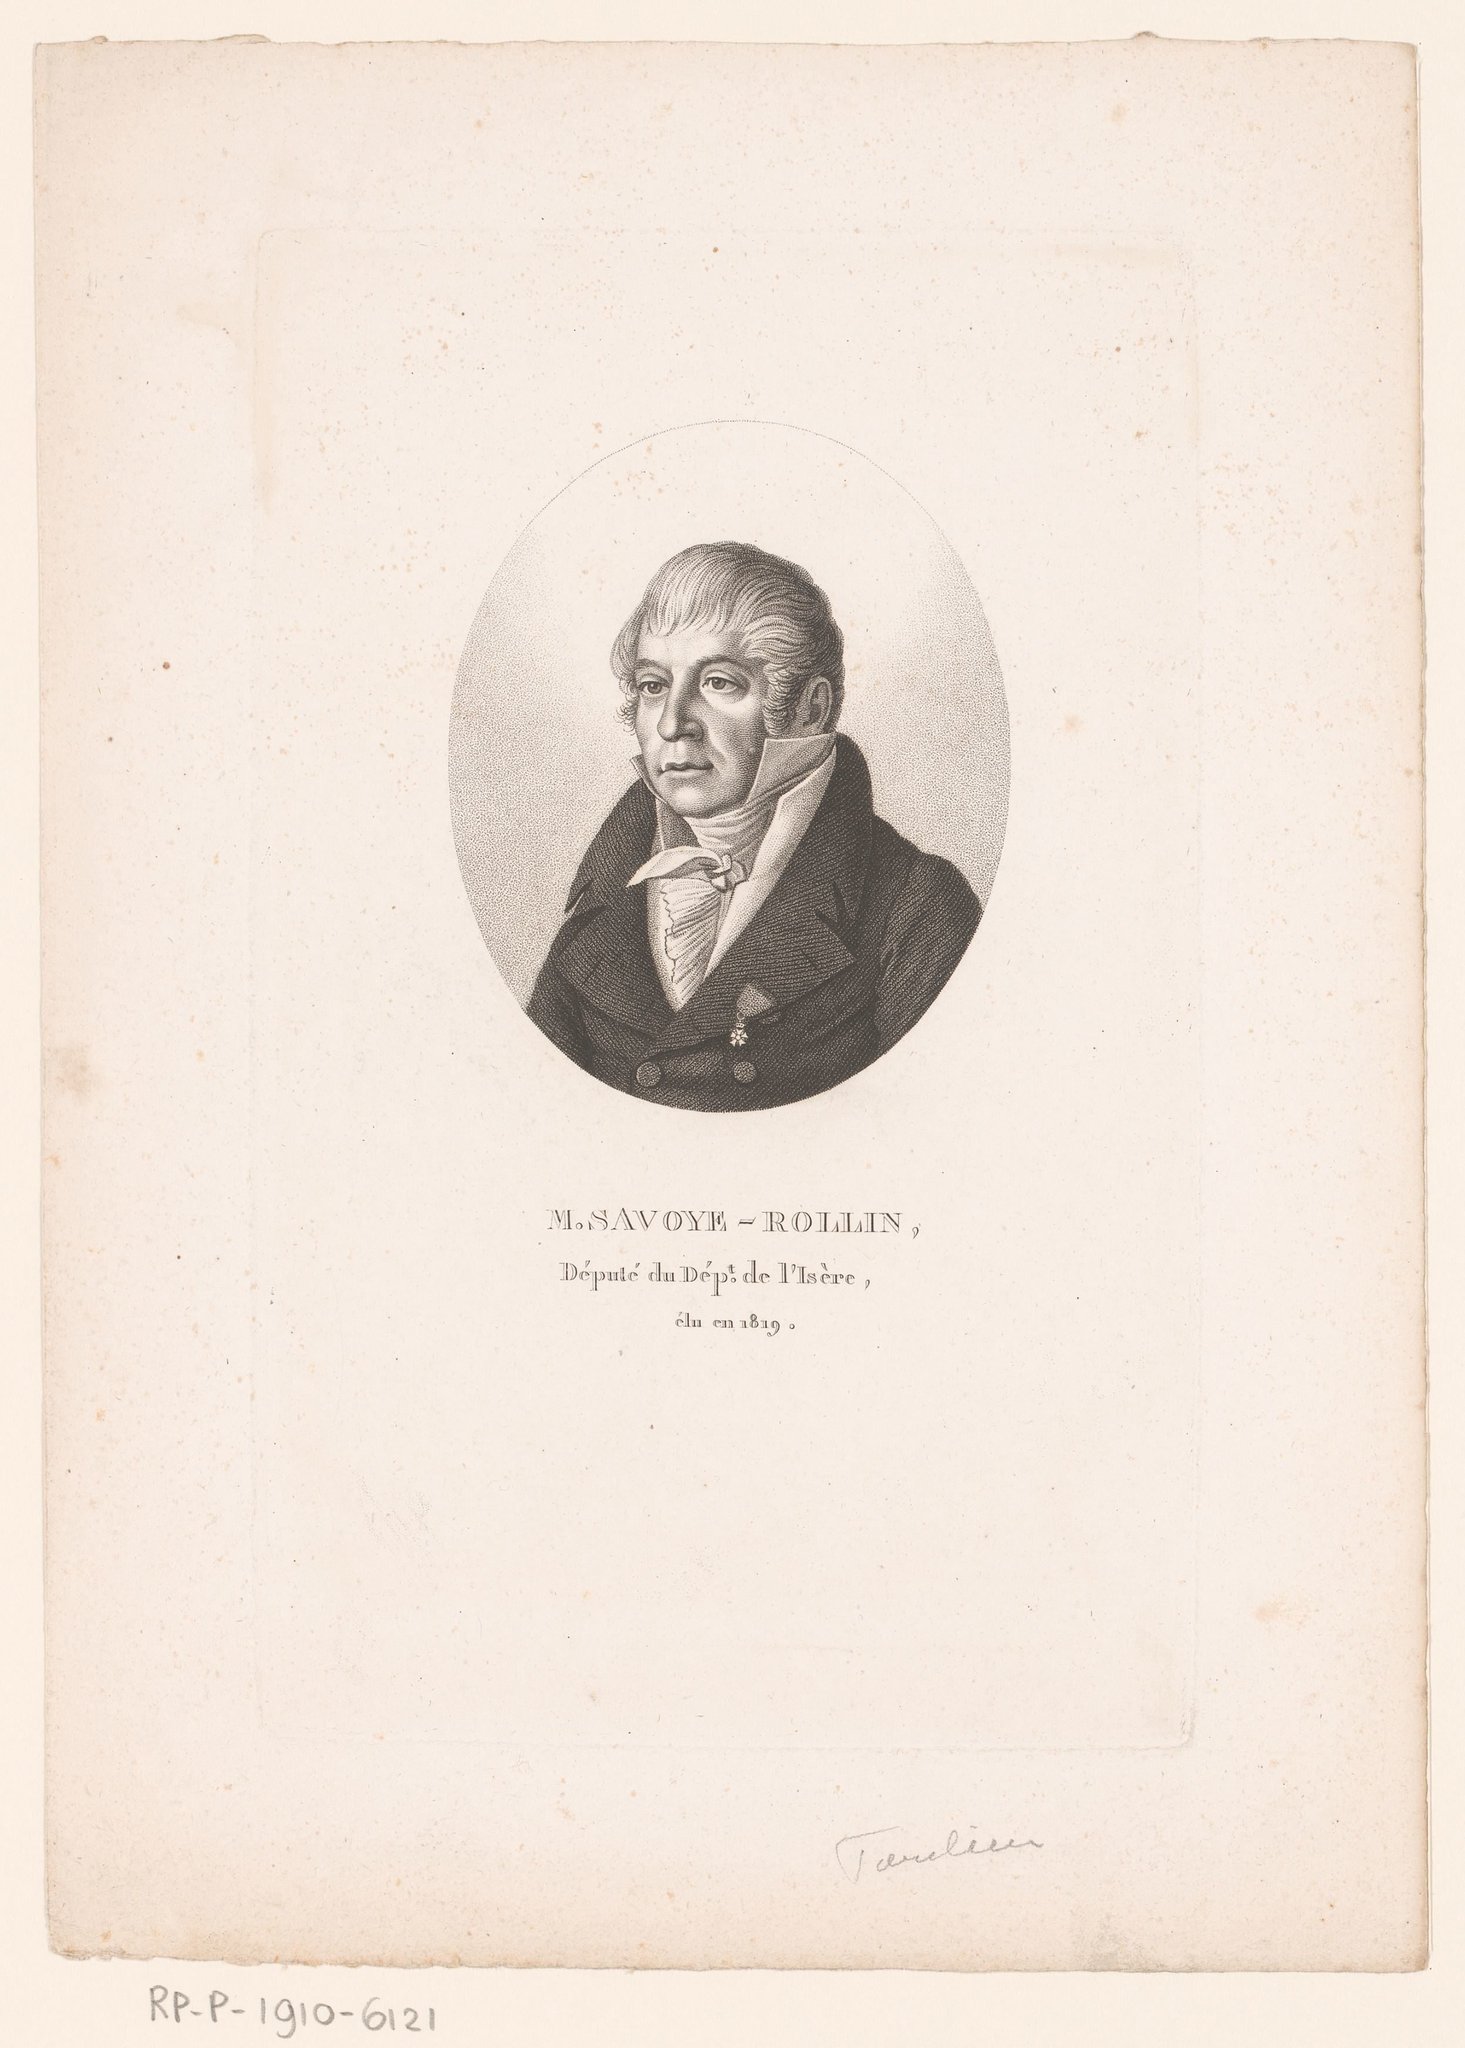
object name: book illustration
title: Portret van Jacques-Fortunat Savoye-Rollin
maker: ambroise tardieu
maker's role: print maker, printer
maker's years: 1788-1841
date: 1820-1821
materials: paper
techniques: engraving, roulette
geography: paris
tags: historical persons, politician, e.g. party leader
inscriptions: collector's mark: Lugt 2228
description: Prent uit: Tardieu, Ambroise. Portraits des députés, écrivains et pairs constitutionnels, défenseurs invariables de la charte et de la loi des élections du 5 février 1817. Parijs: Tardieu, Ambroise, 1820-1821.